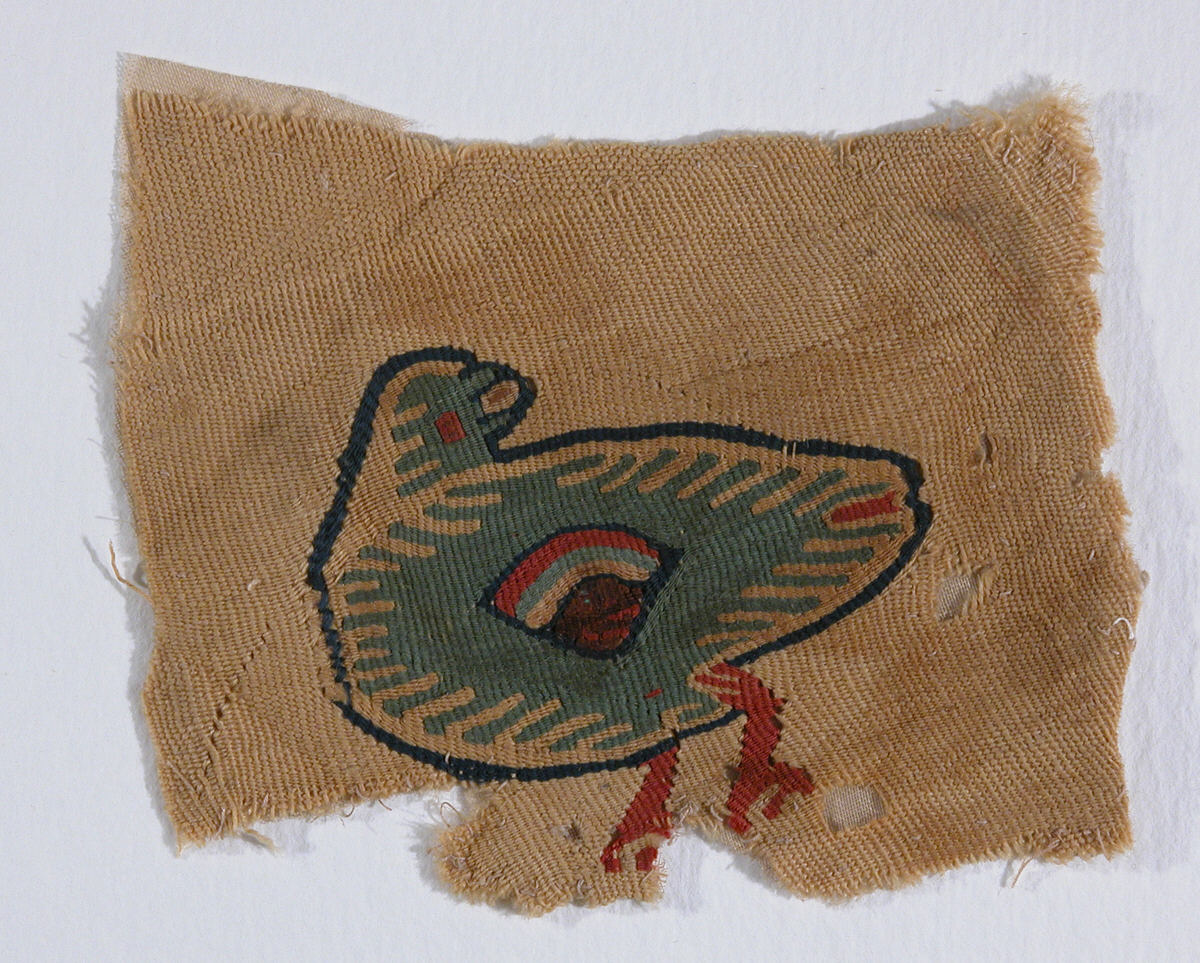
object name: textile fragment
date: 401-600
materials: wool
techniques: weave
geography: egypt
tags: birds